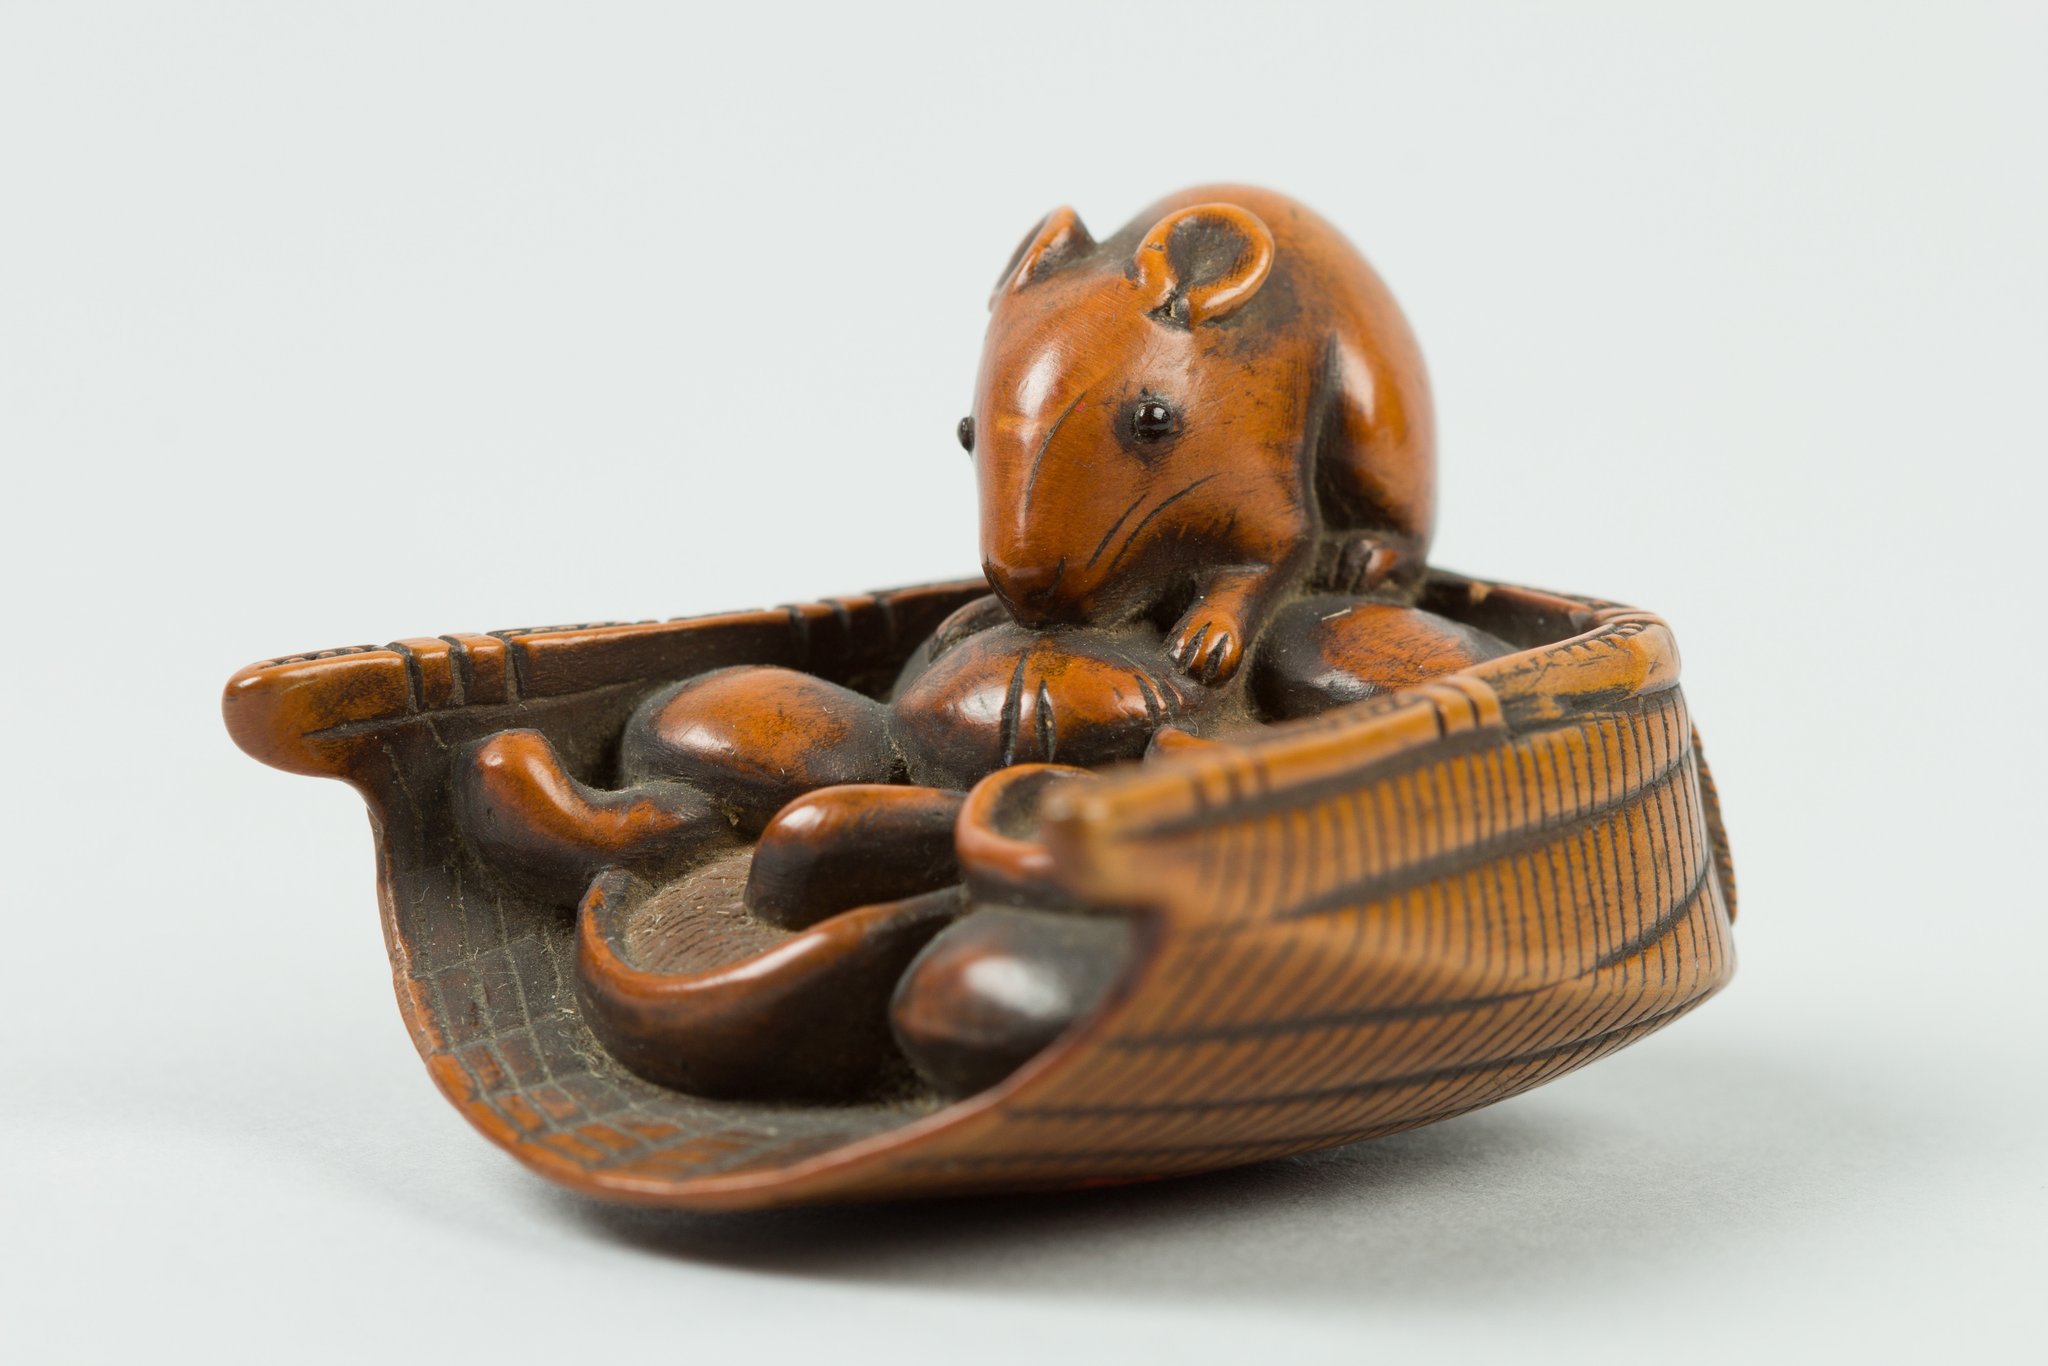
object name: netsuke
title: Netsuke of Mouse in a Basket of Mushrooms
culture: japanese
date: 1801-1900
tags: mice